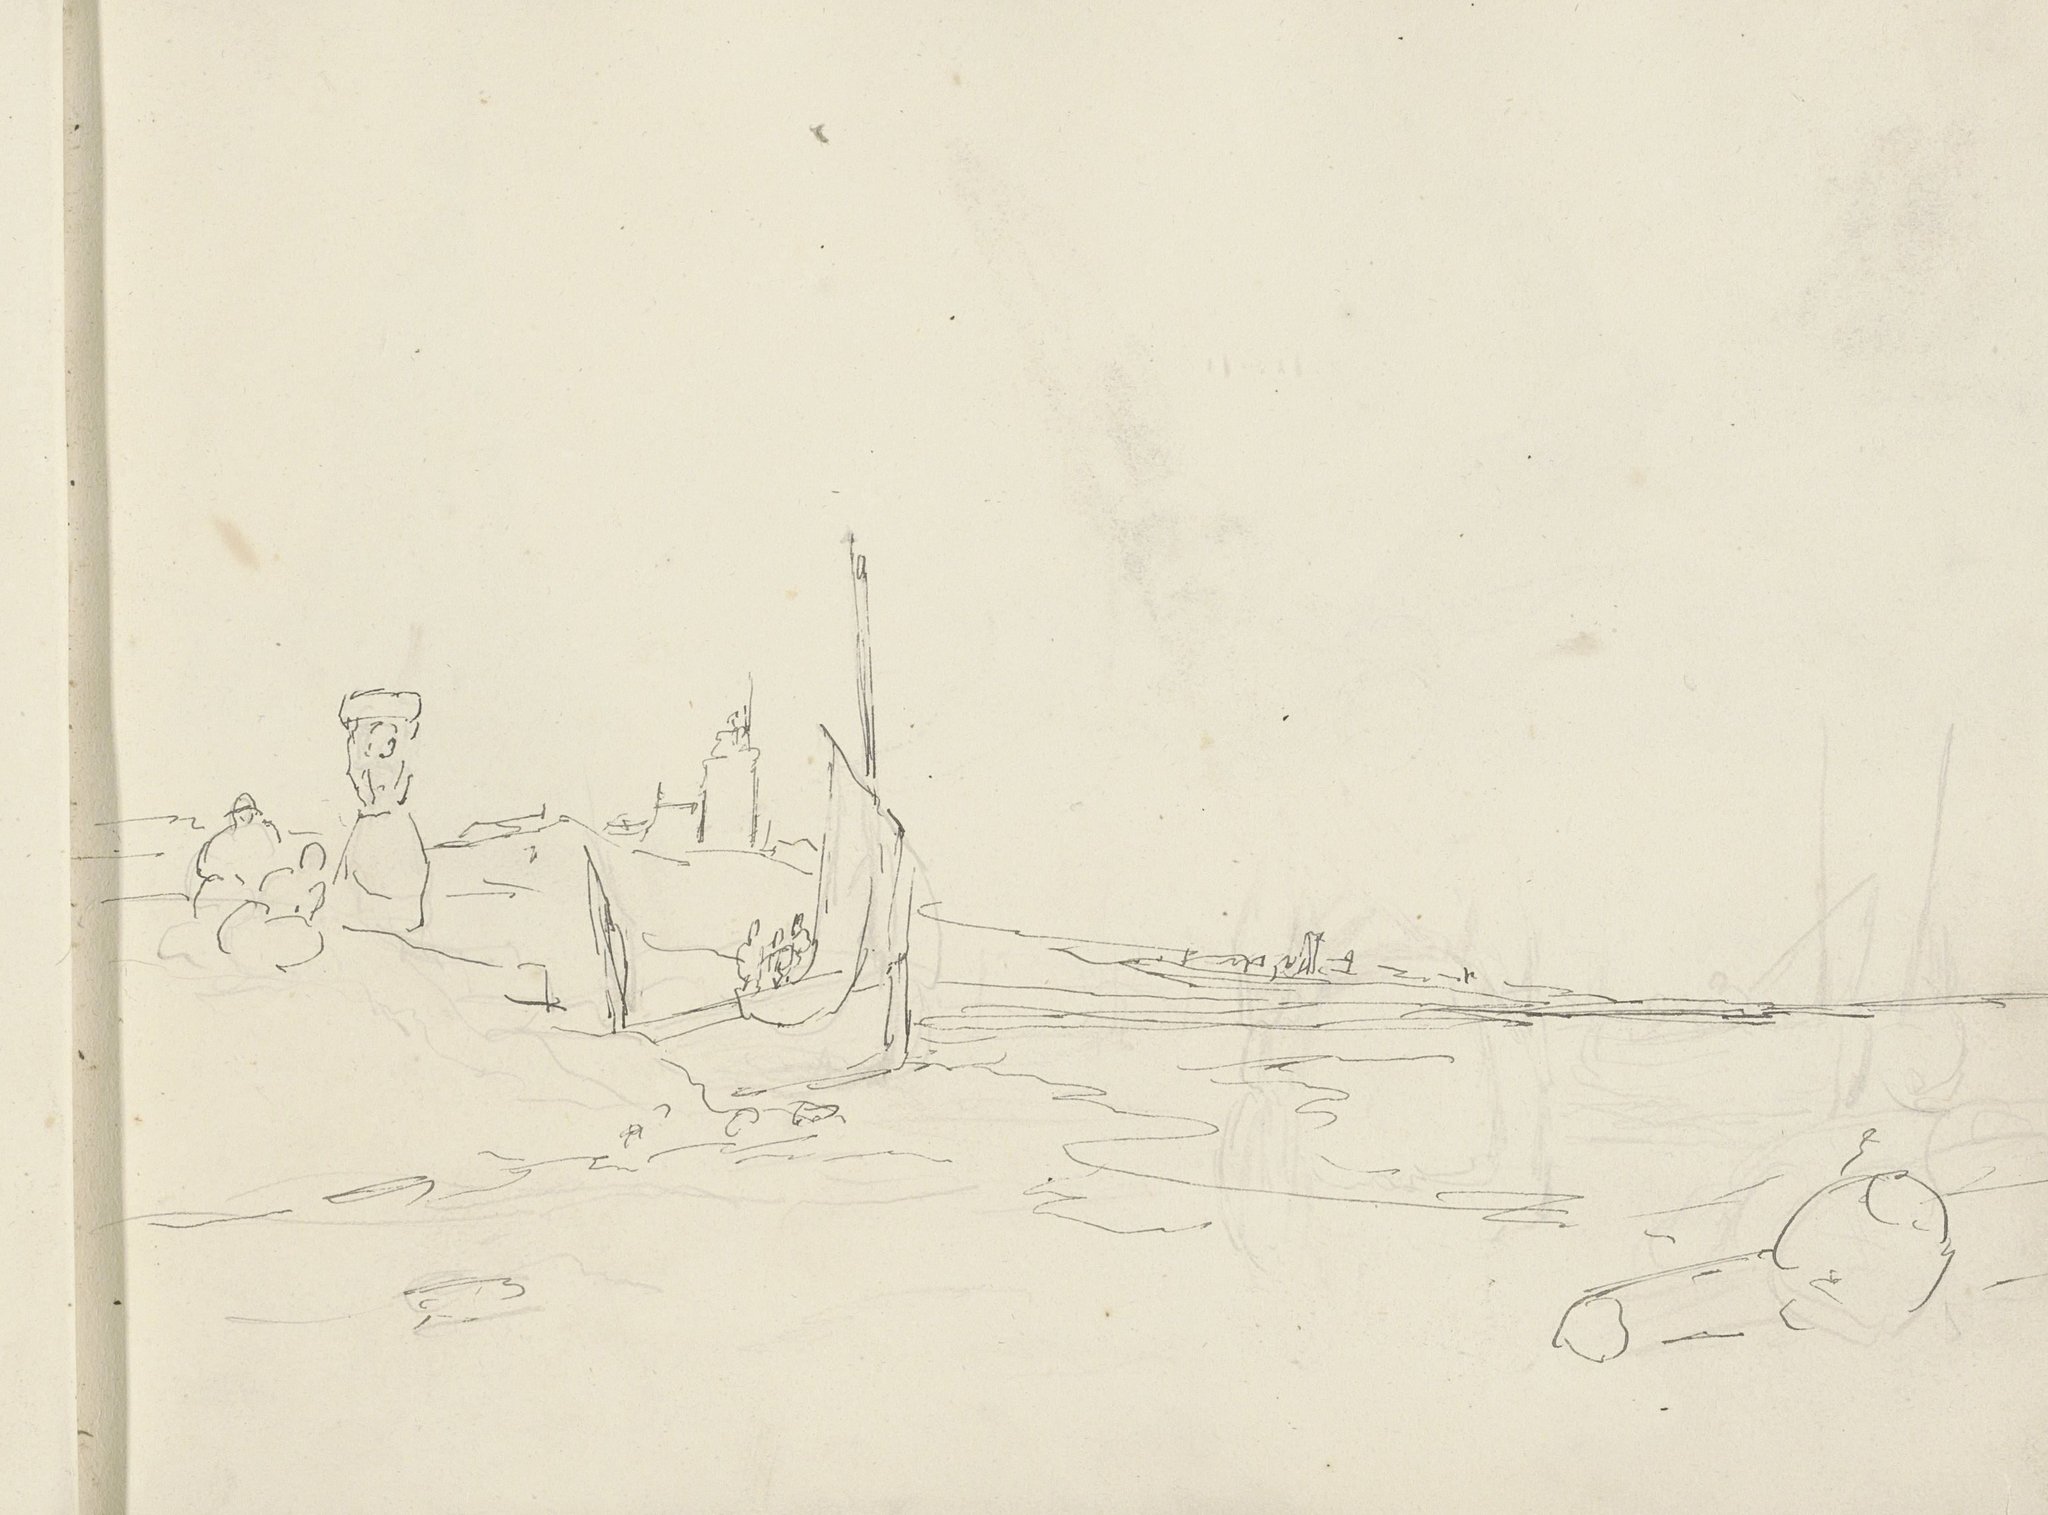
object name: sketchbook leaf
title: Kustgezicht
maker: petrus johannes schotel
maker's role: draughtsman, painter, print maker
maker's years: 1808-1865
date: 1825-1875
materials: ink, paper, pencil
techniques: pen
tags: coast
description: Blad 18 recto uit een schetsboek met 44 bladen.